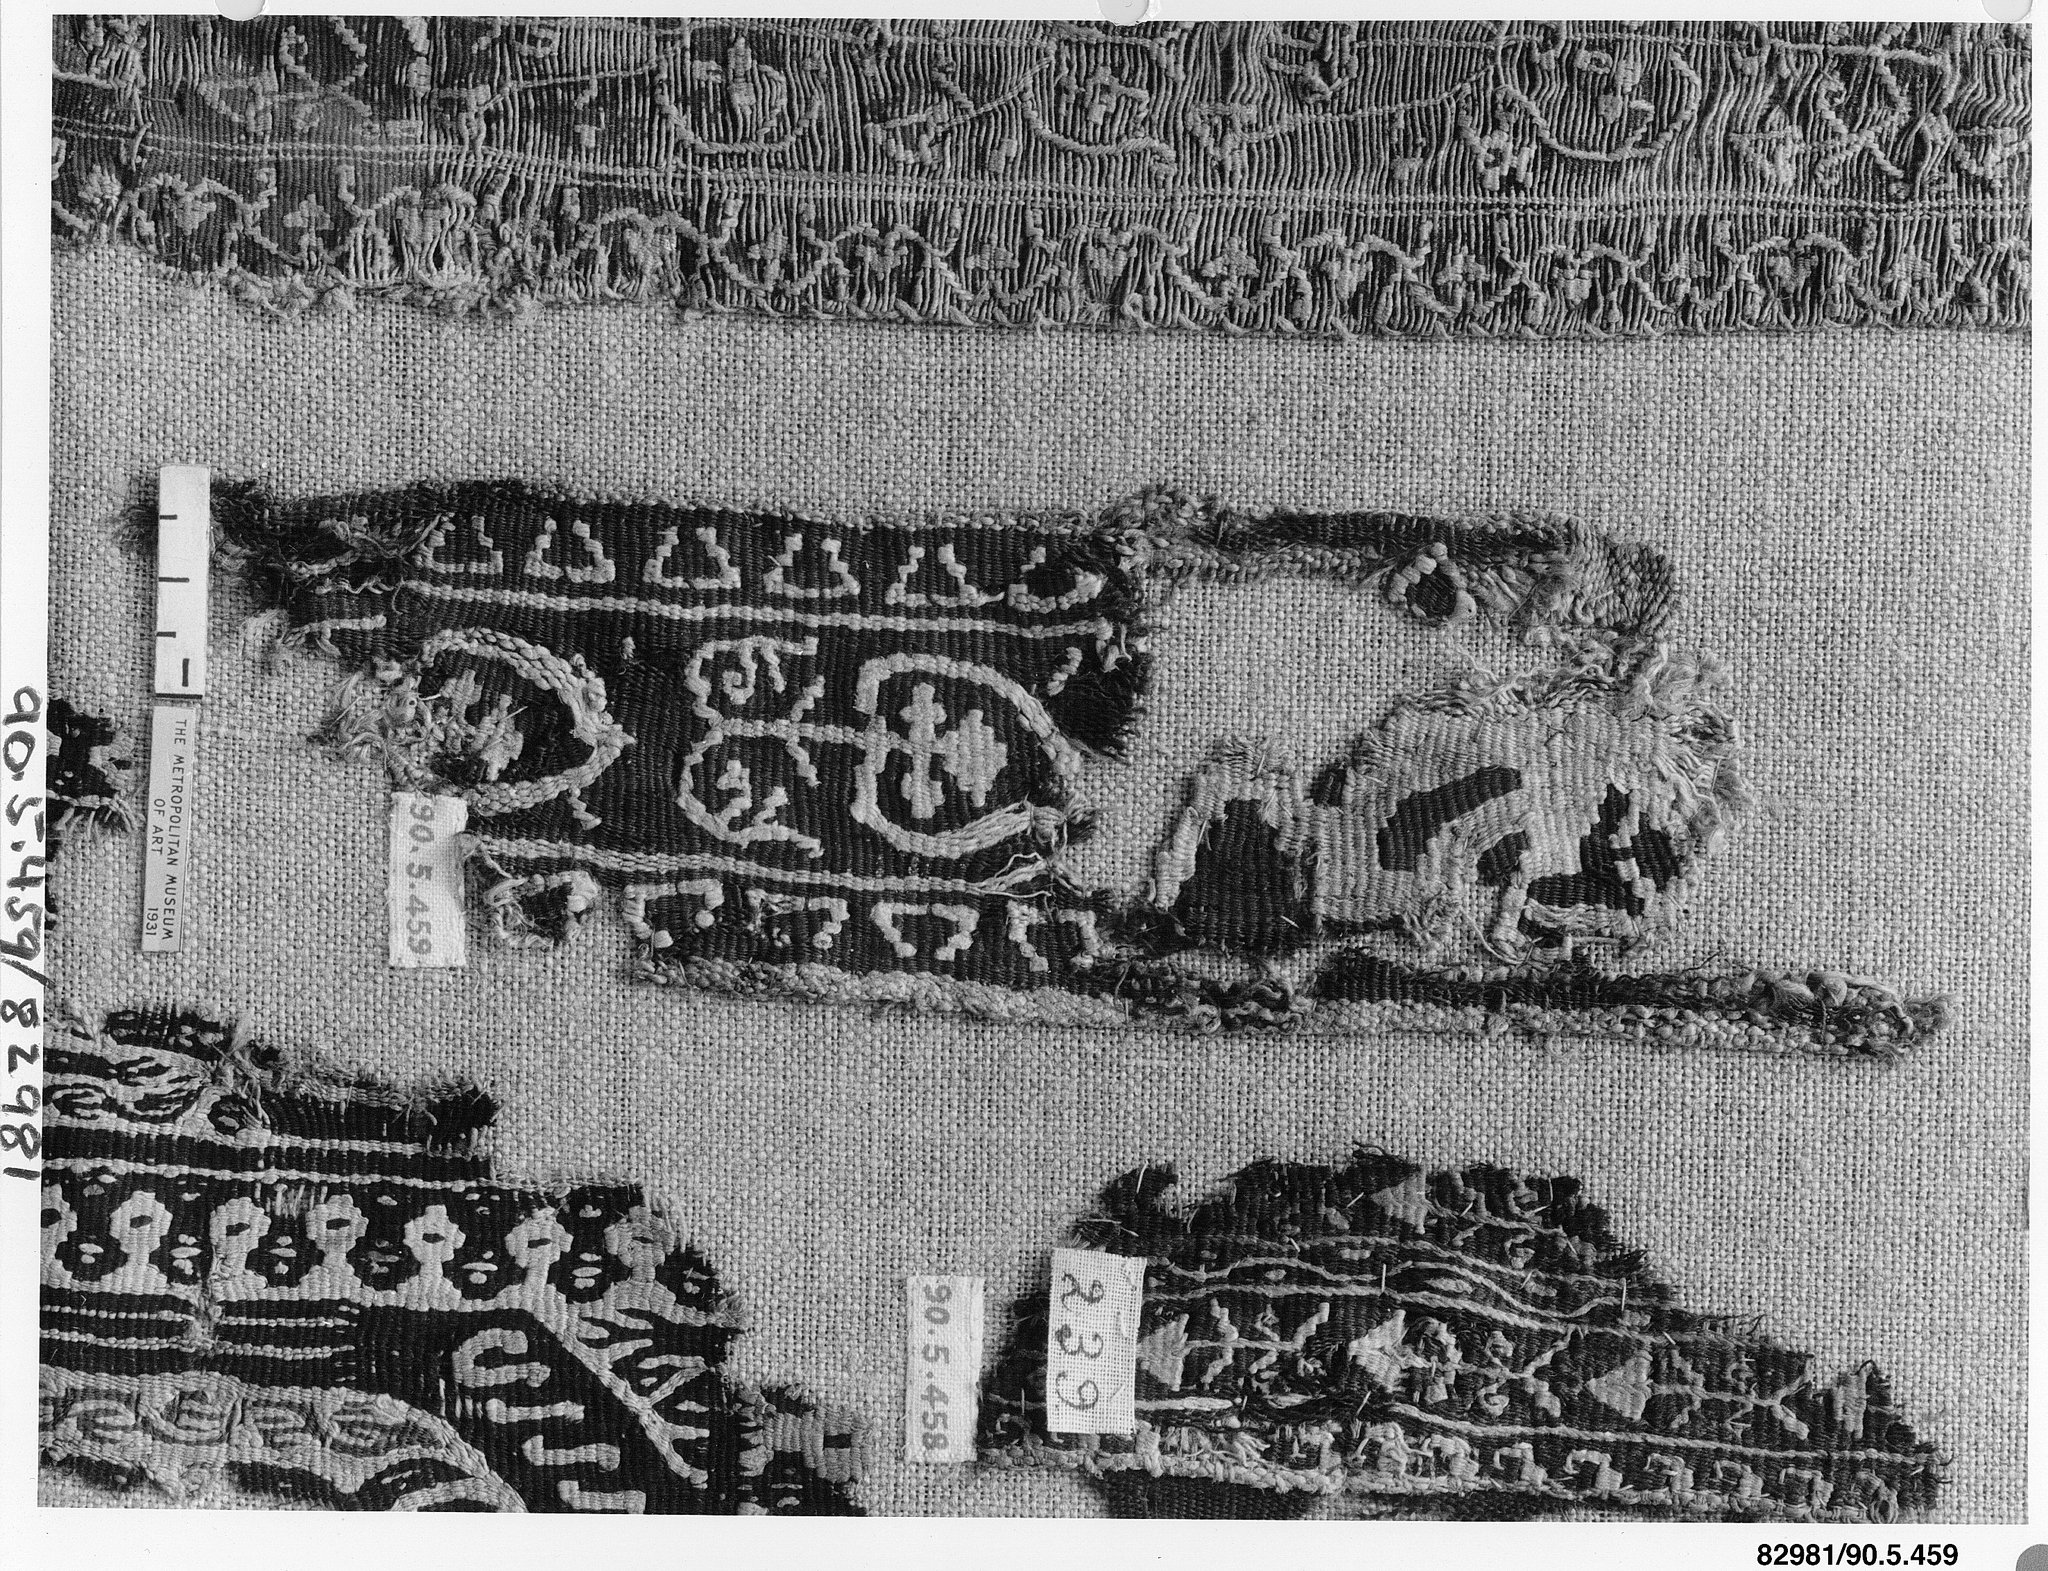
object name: textile fragment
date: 401-500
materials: linen, wool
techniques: weave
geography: egypt